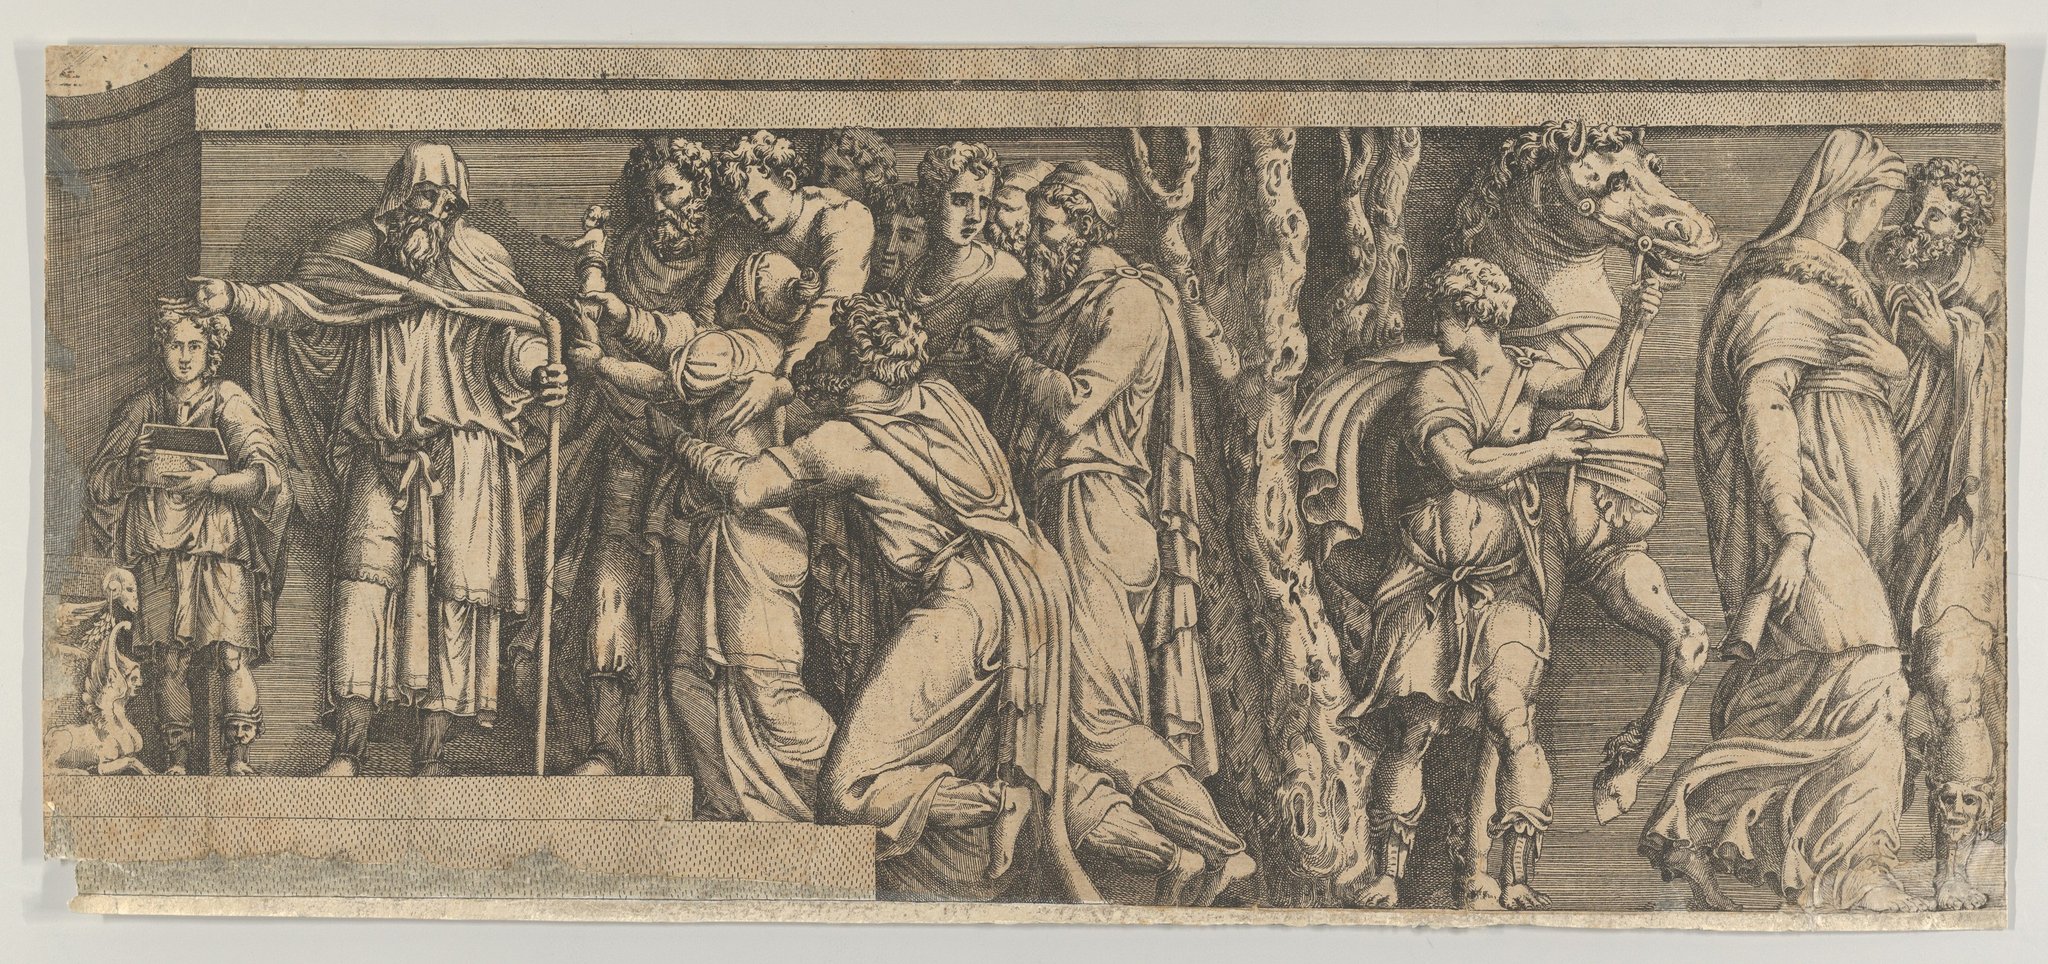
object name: print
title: Statue of Niobe and her Worshippers, with Apollo and Diana and other Figures, after Polidoro da Caravaggio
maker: anonymous, school of fontainebleau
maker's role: artist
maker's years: 1500-1600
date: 1543-1547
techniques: etching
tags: men,apollo,diana,horses,praying